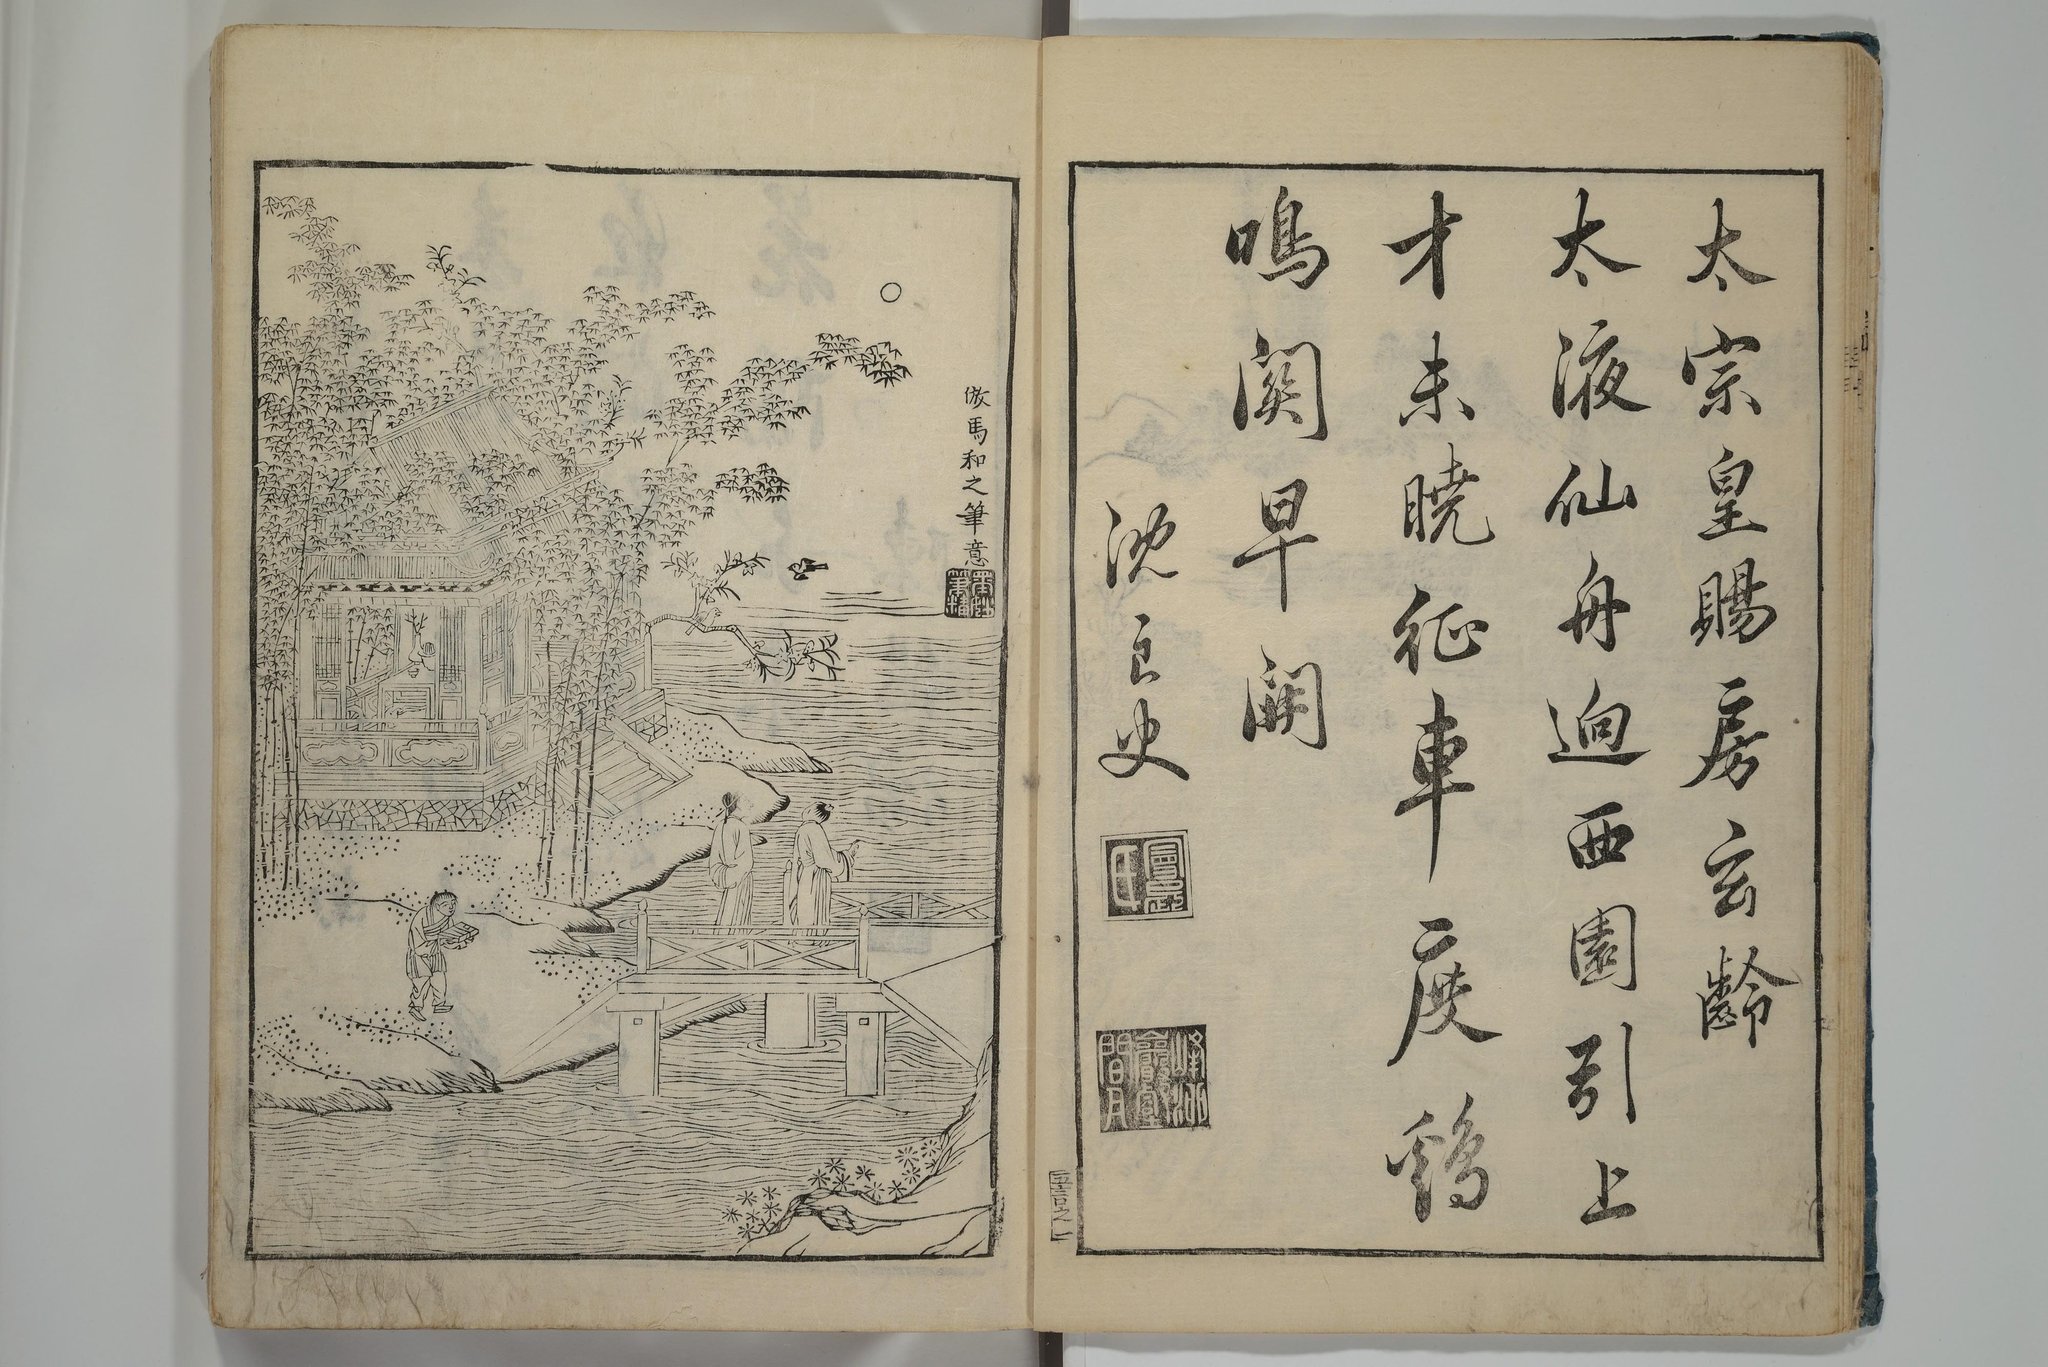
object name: illustrated book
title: Primer on Eight Varieties of Painting (Hasshu gafu) 八集画譜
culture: japanese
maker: unidentified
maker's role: artist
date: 1672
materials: ink, paper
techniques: woodblock print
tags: human figures,houses,bridges,trees